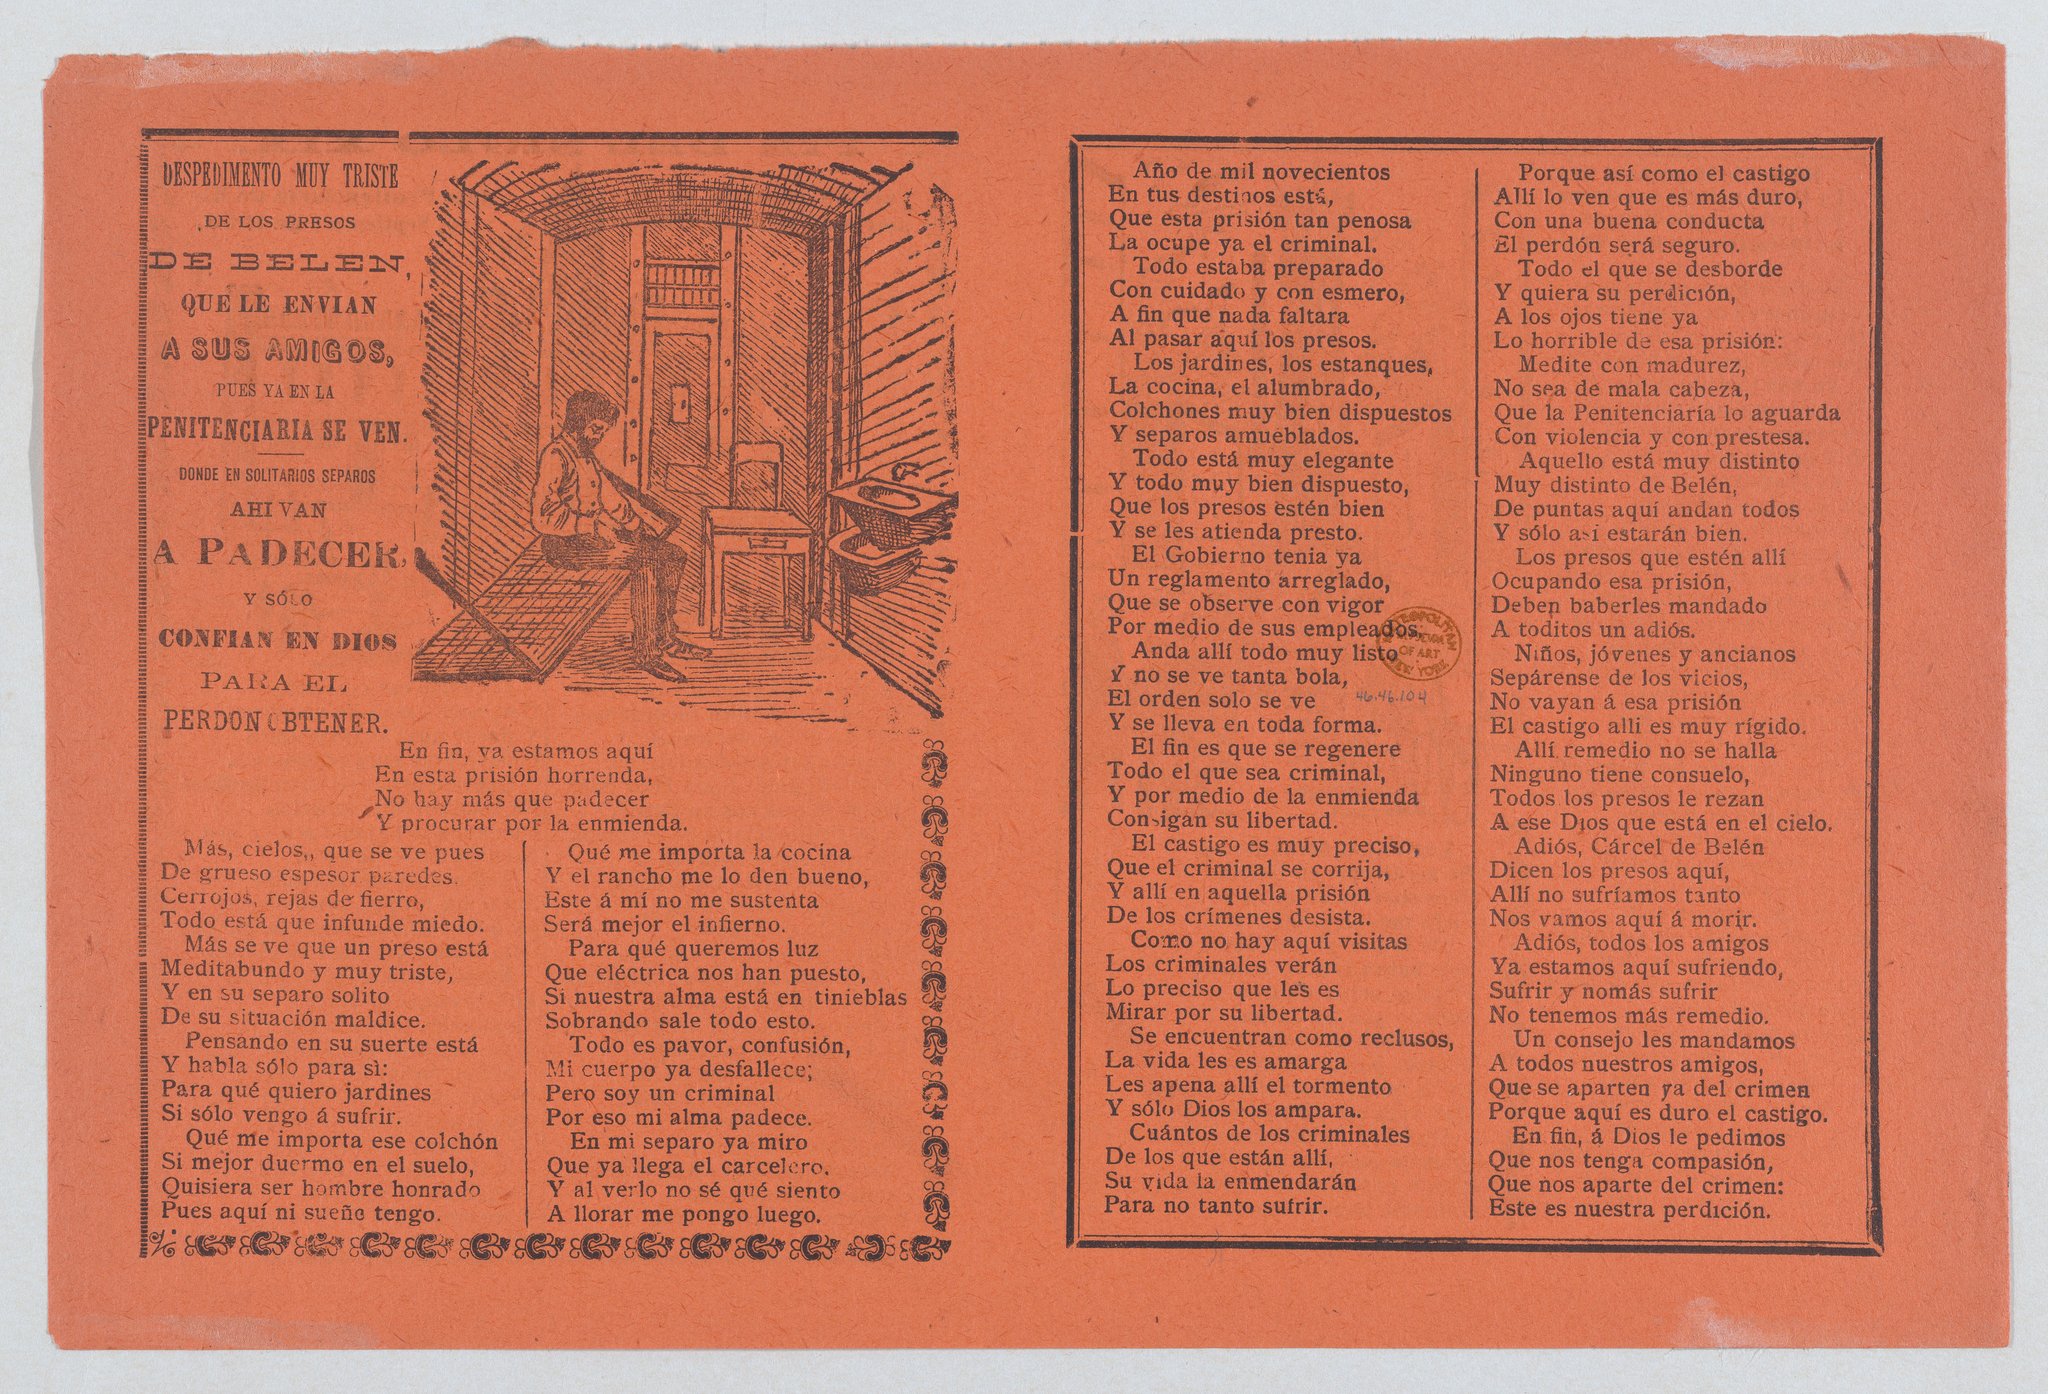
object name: print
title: Broadsheet relating to life in prison, a man in his jail cell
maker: josé guadalupe posada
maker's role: artist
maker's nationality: mexican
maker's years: 1852-1913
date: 1900-1913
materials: paper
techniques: letterpress, lithography